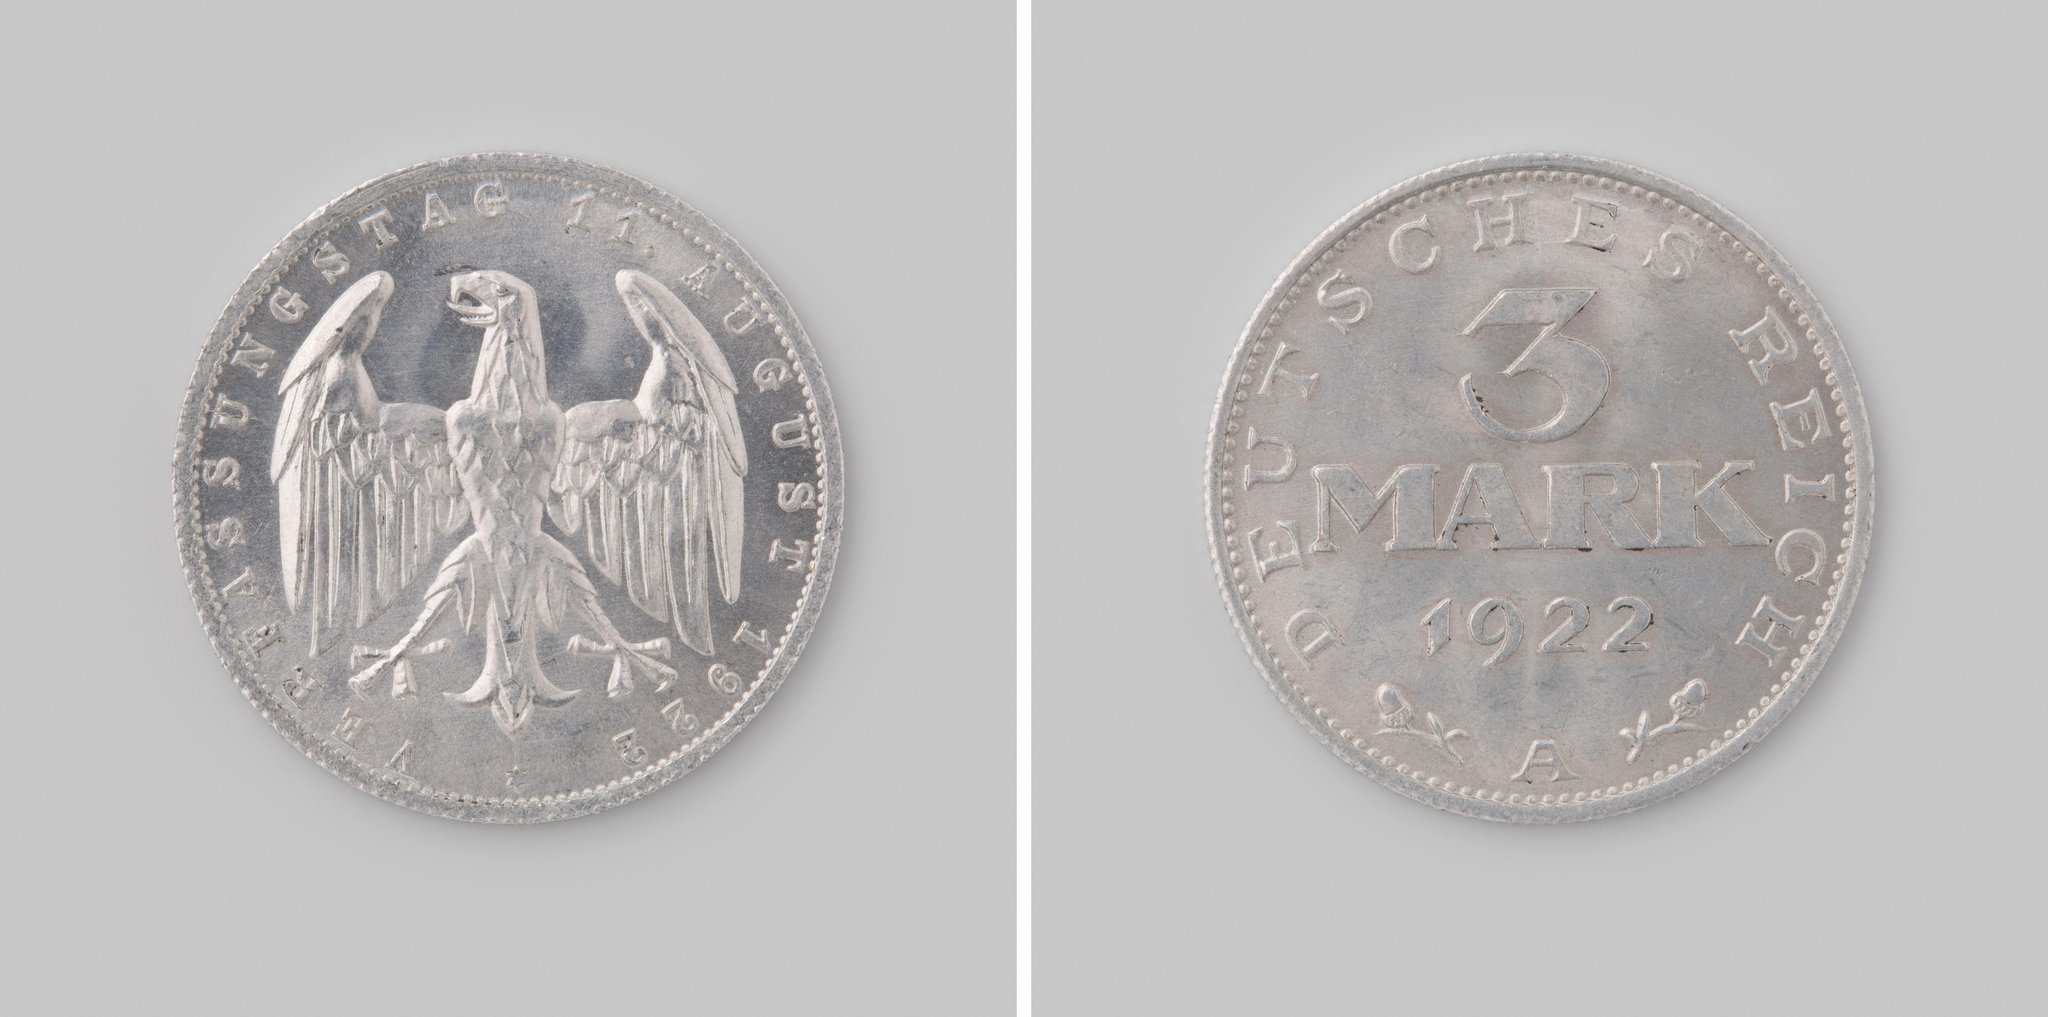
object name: coin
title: 3 Mark uit Duitsland, 1922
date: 1922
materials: aluminum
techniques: striking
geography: berlin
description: Aluminium herdenkingsmunt van de grondwet. Voorzijde: enkelkoppige adelaar met datum 11. August 1922 in omschrift. Keerzijde: waarde-aanduiding in twee regels, waaronder jaartal. Daaronder letter A.Kartelrand.